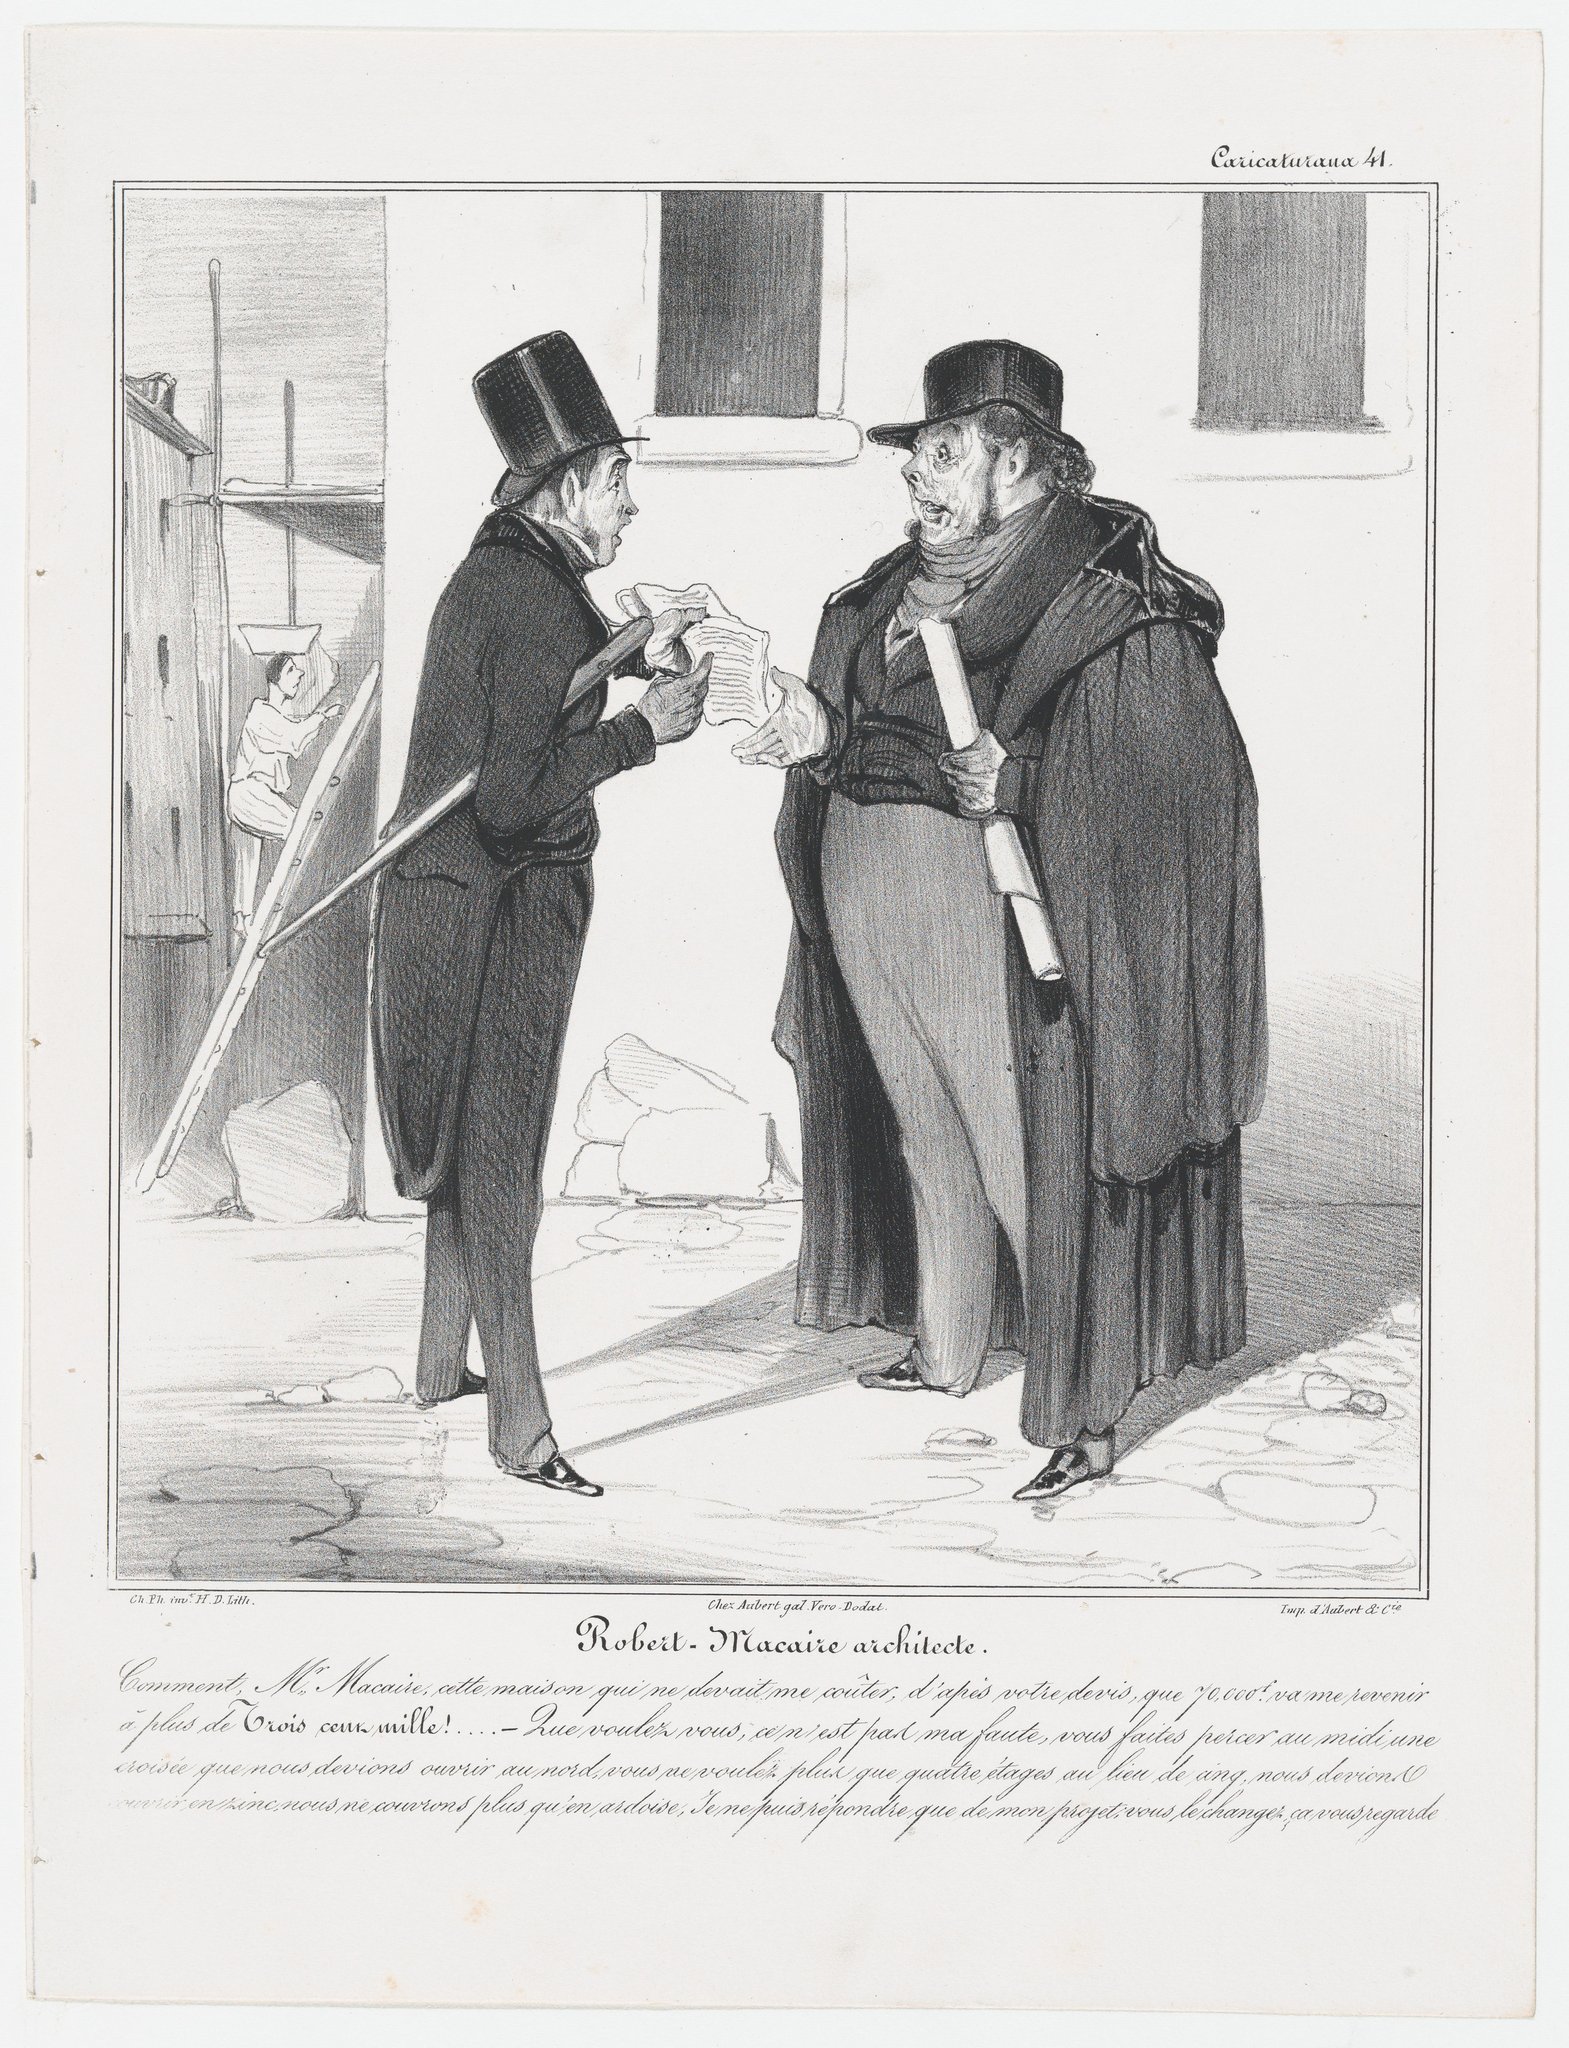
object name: print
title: Plate 41: Robert Macaire, architect, from 'Caricaturana,' published in Les Robert Macaires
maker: honoré daumier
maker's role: artist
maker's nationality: french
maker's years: 1808-1879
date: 1838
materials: paper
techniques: lithograph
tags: satire,men